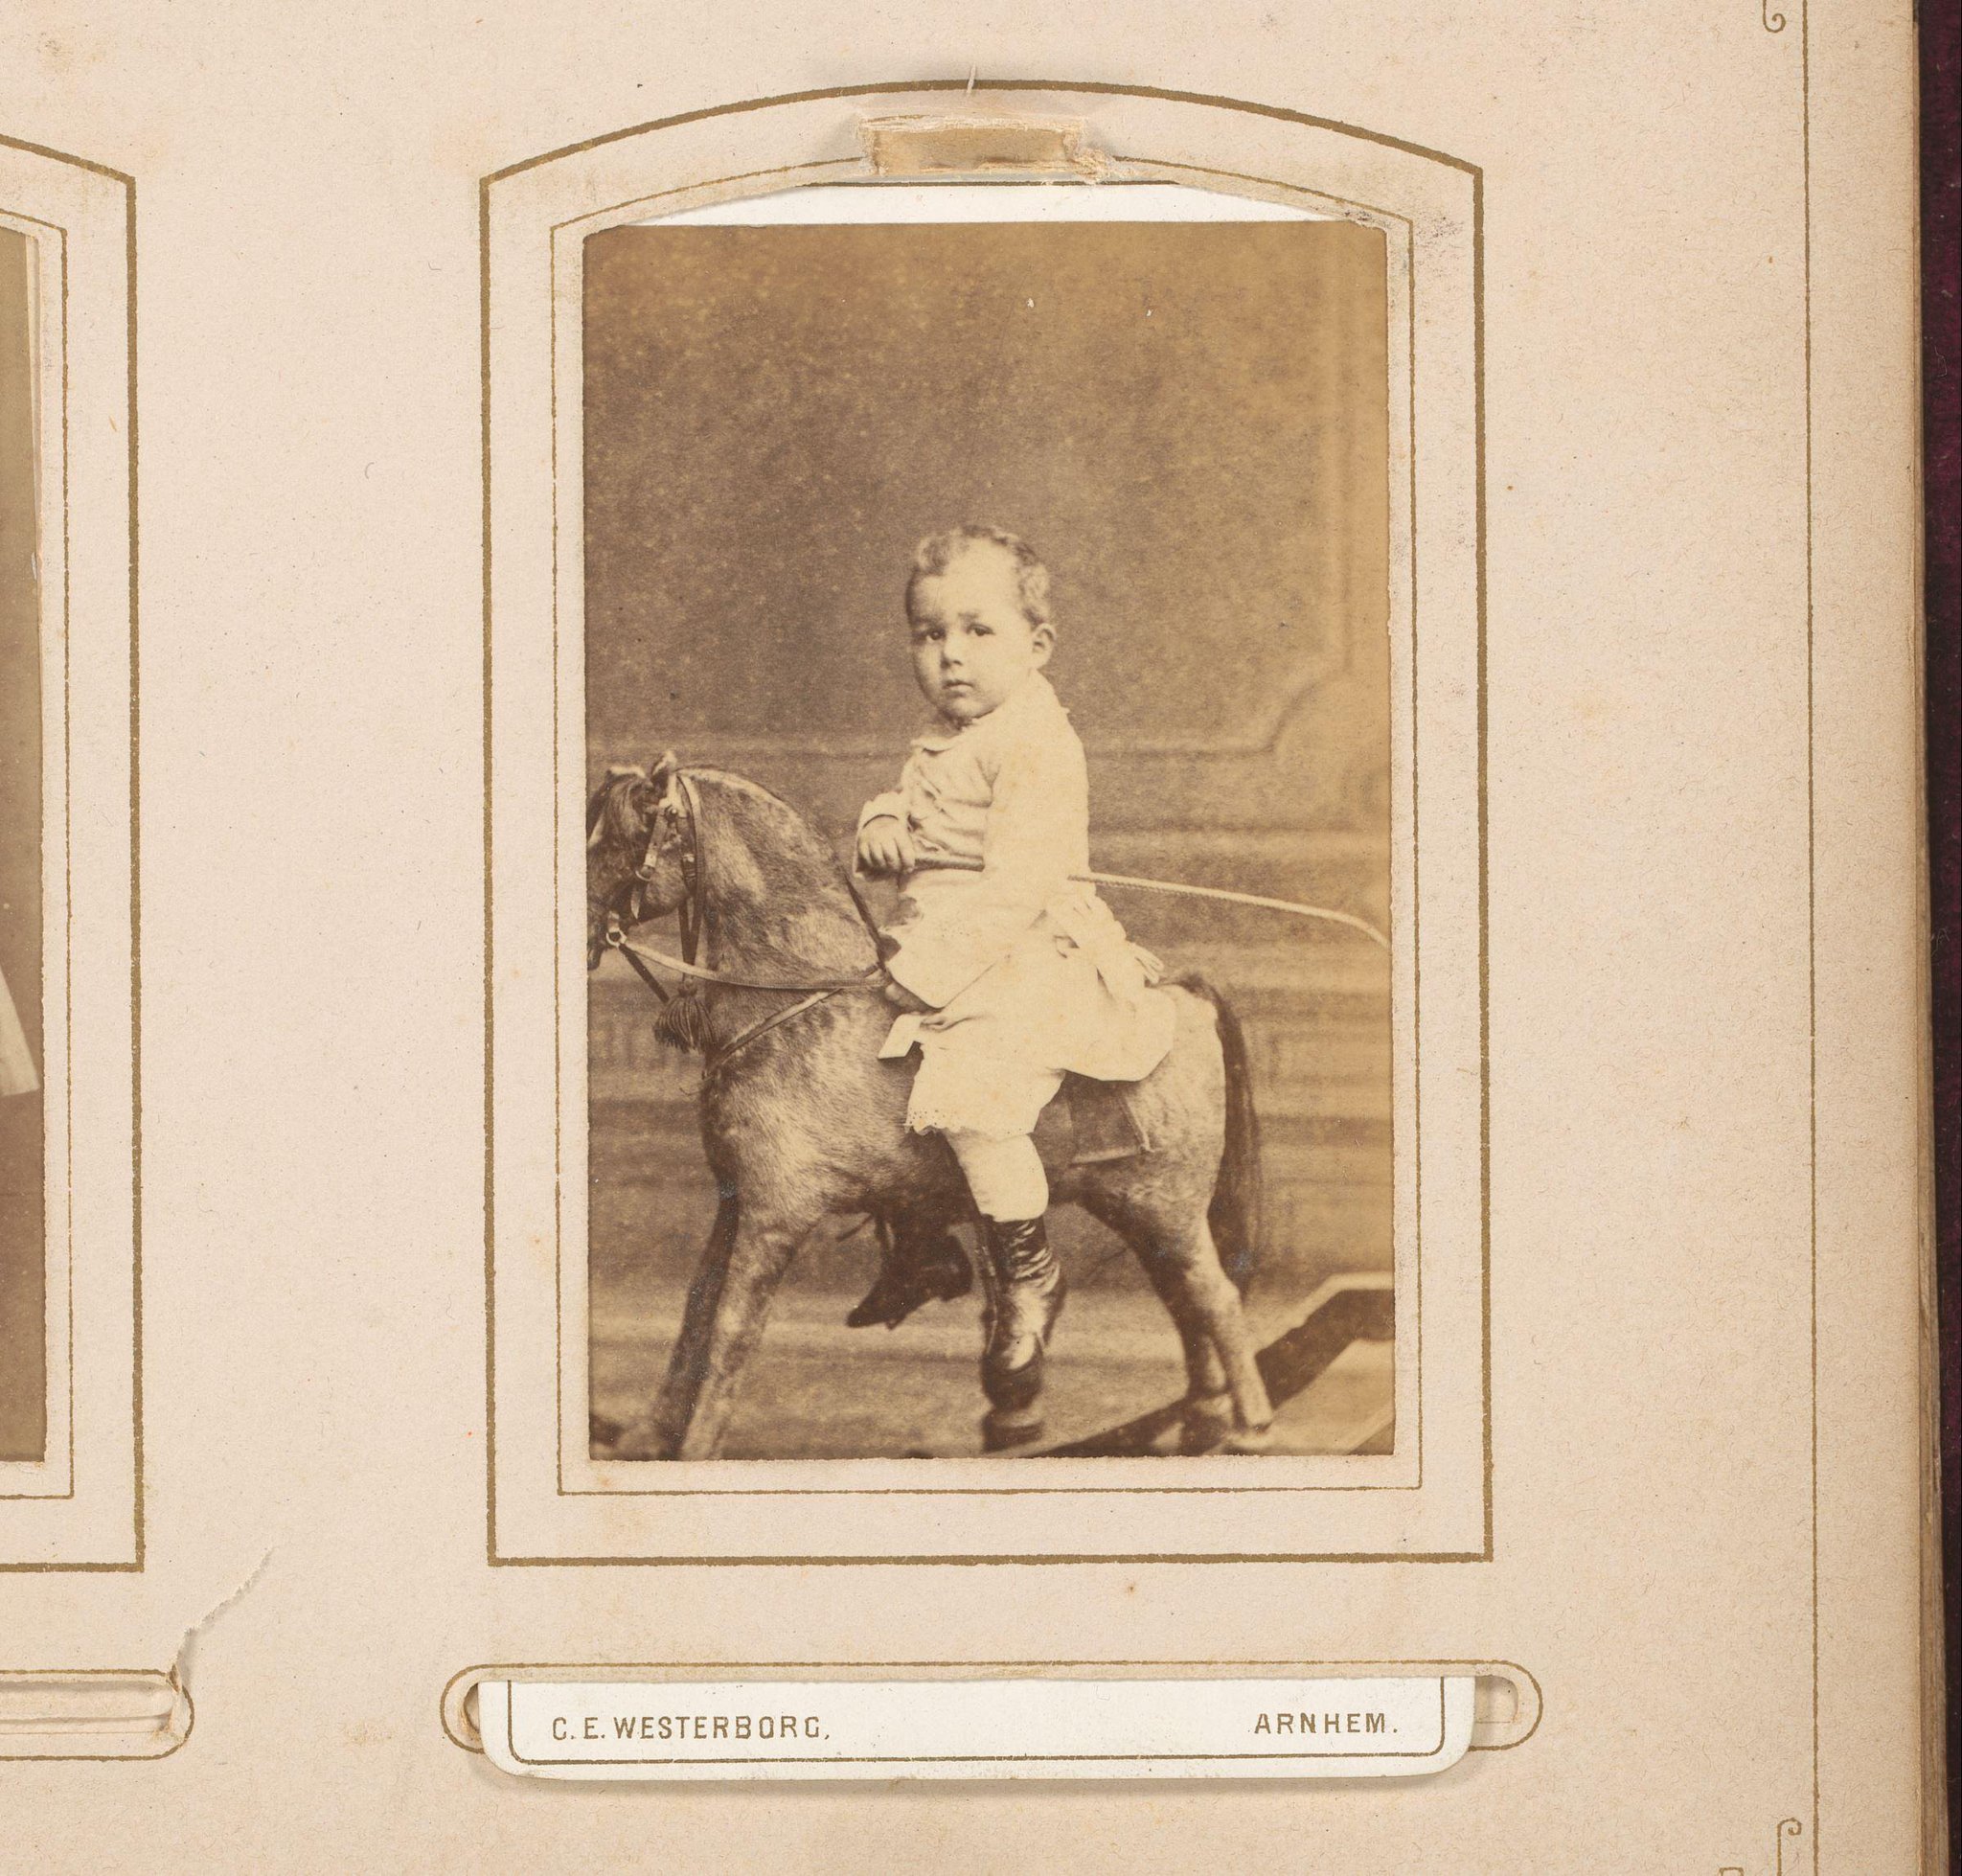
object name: photograph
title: Portret van een jongen op een hobbelpaard, met zweep onder de arm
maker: carel eduard westerborg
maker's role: fotograaf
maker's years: 1842-1916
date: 1861-1900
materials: cardboard, photographic support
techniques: albumen print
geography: arnhem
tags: historical persons, toddler (male), rocking-horse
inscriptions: inscription: ‘C. E. WESTERBORG/ Photograaf/ Vossenstraat B 66/ Arnhem/ Voor nabestelling worden alle/ negatieven bewaard.’